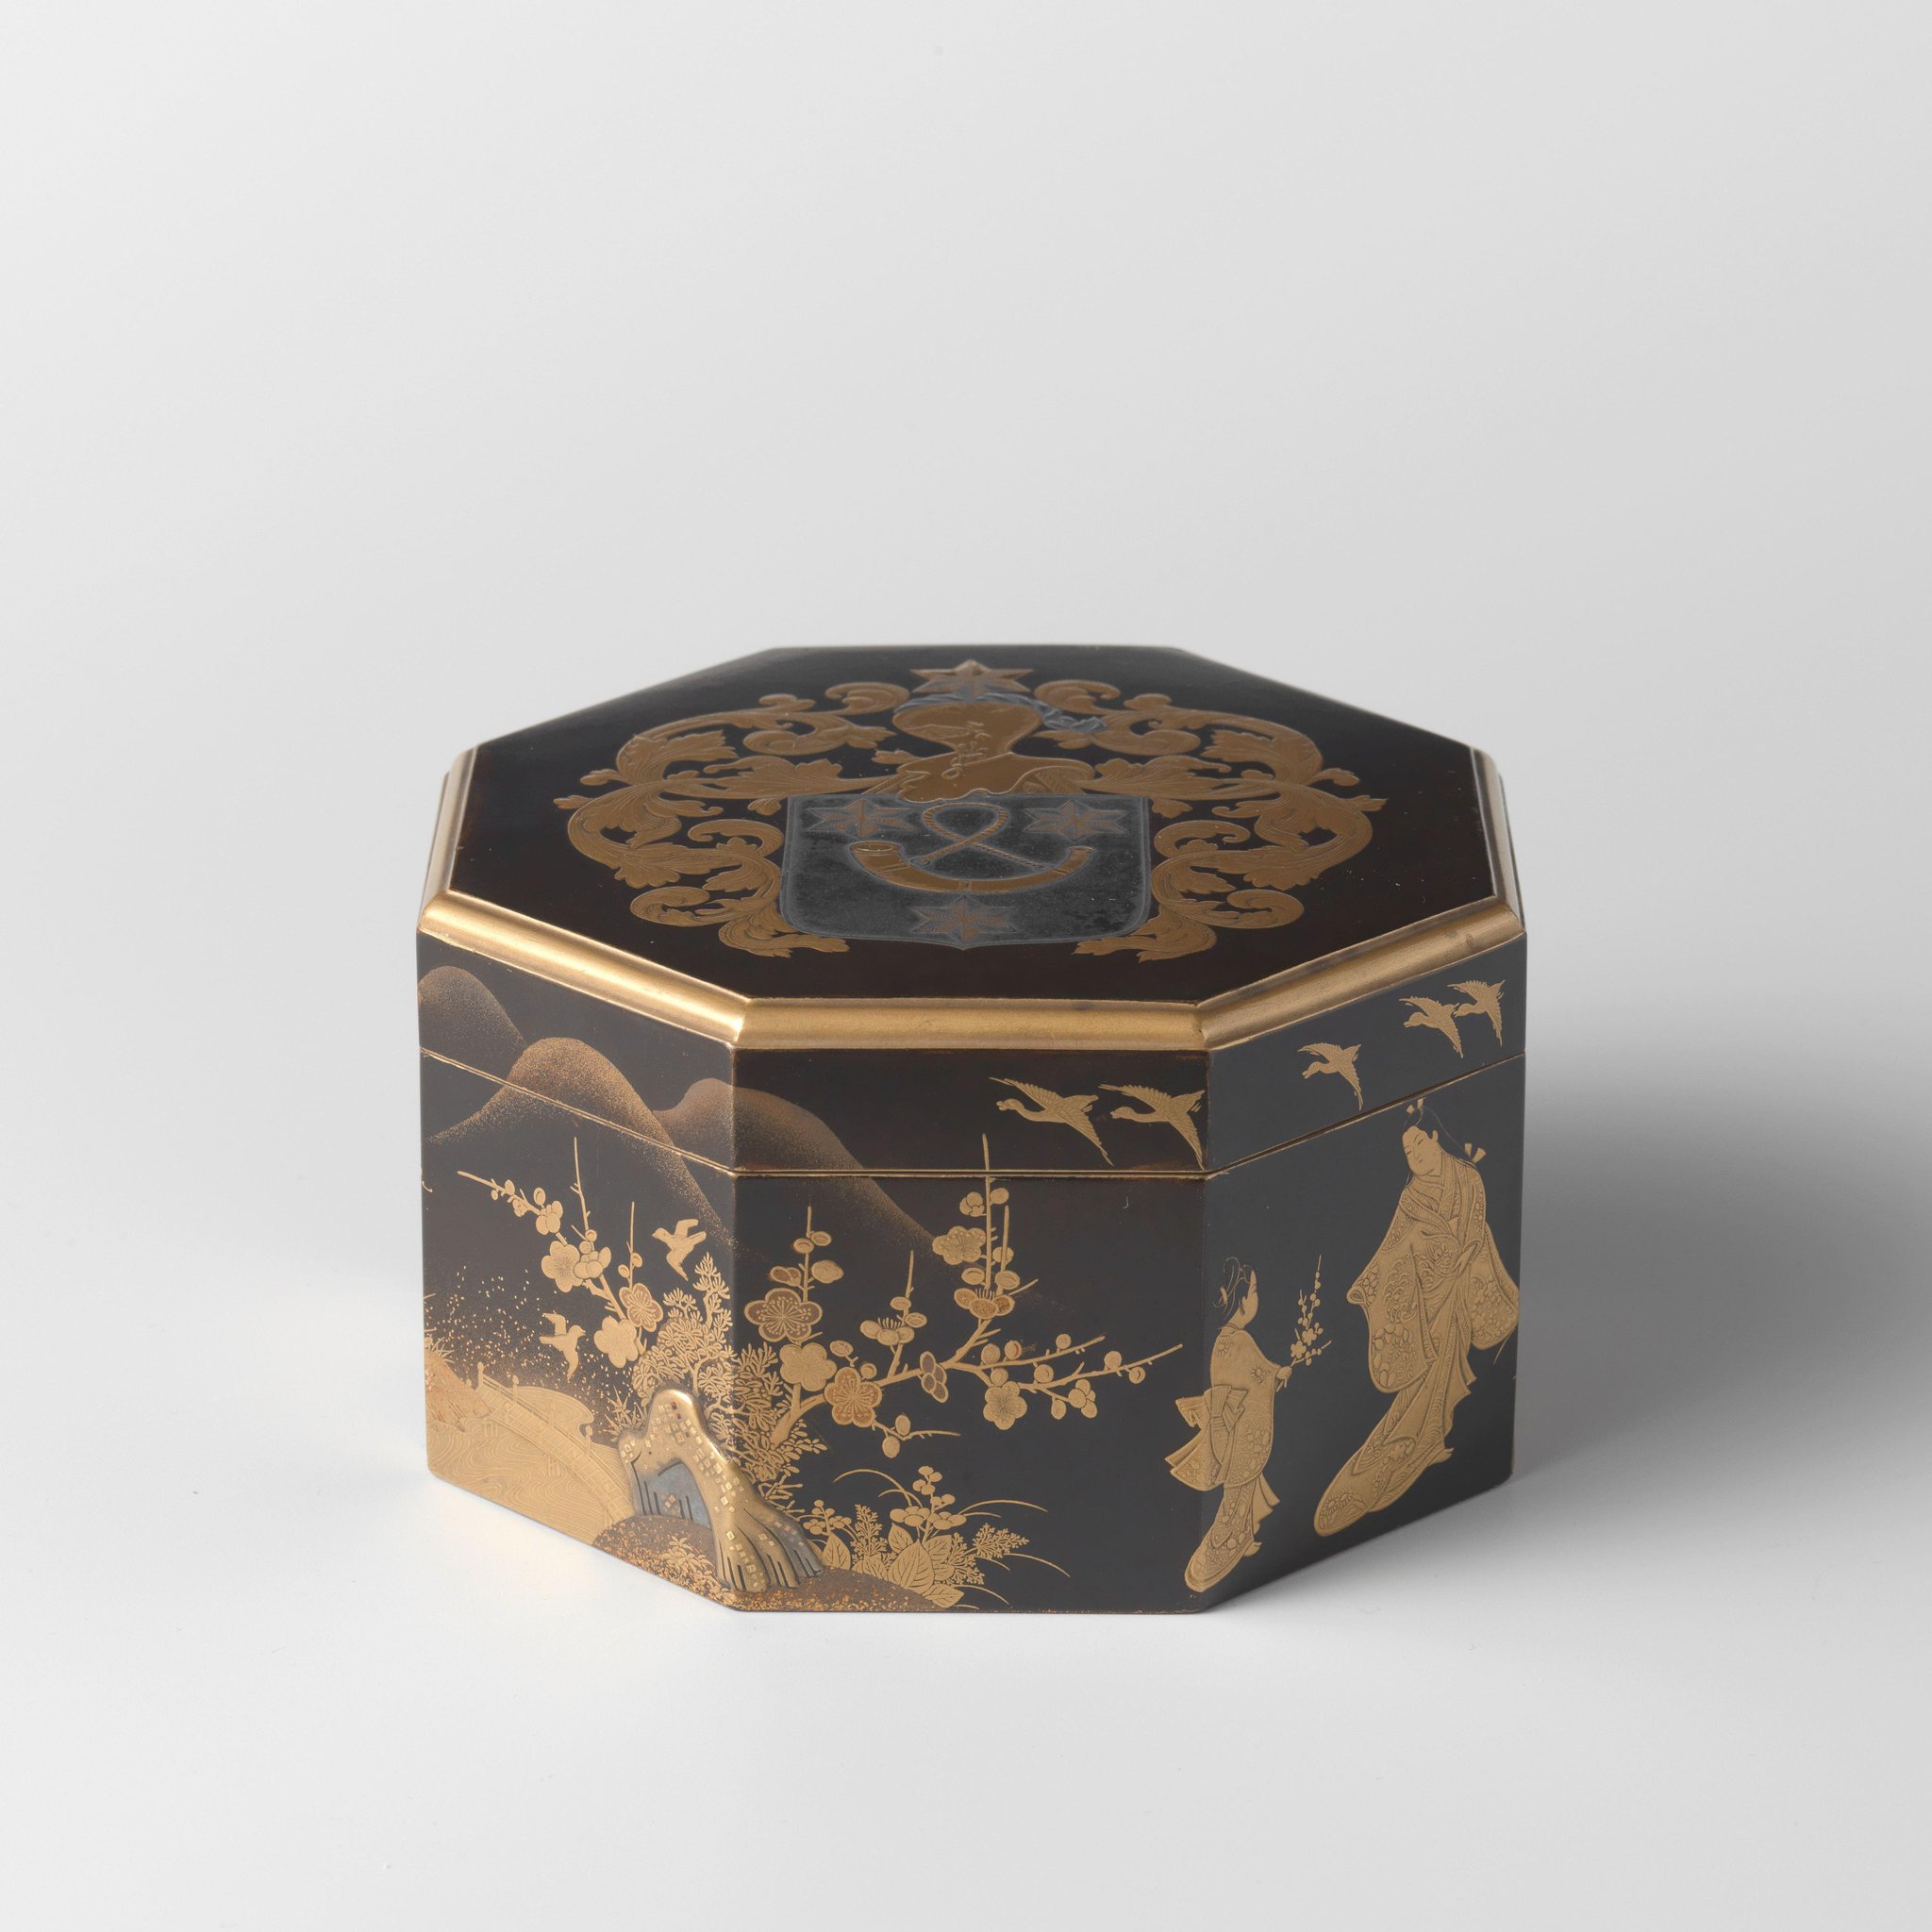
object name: lakdoos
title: Box with Joan van Hoorn’s coat of arms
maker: Anonymous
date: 1700-1710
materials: wood, lacquer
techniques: lacquer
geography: japan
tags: amsterdam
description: Japanese lacquerware was highly prized in both Asia and Europe. This lacquer box, featuring Joan van Hoorn’s coat of arms on the lid, is decorated along the sides with traditional Japanese motifs. A significant portion of Van Hoorn’s collection remained in the possession of the descendants of his daughter Petronella at Rosendael Castle in Gelderland until in the 20th century.